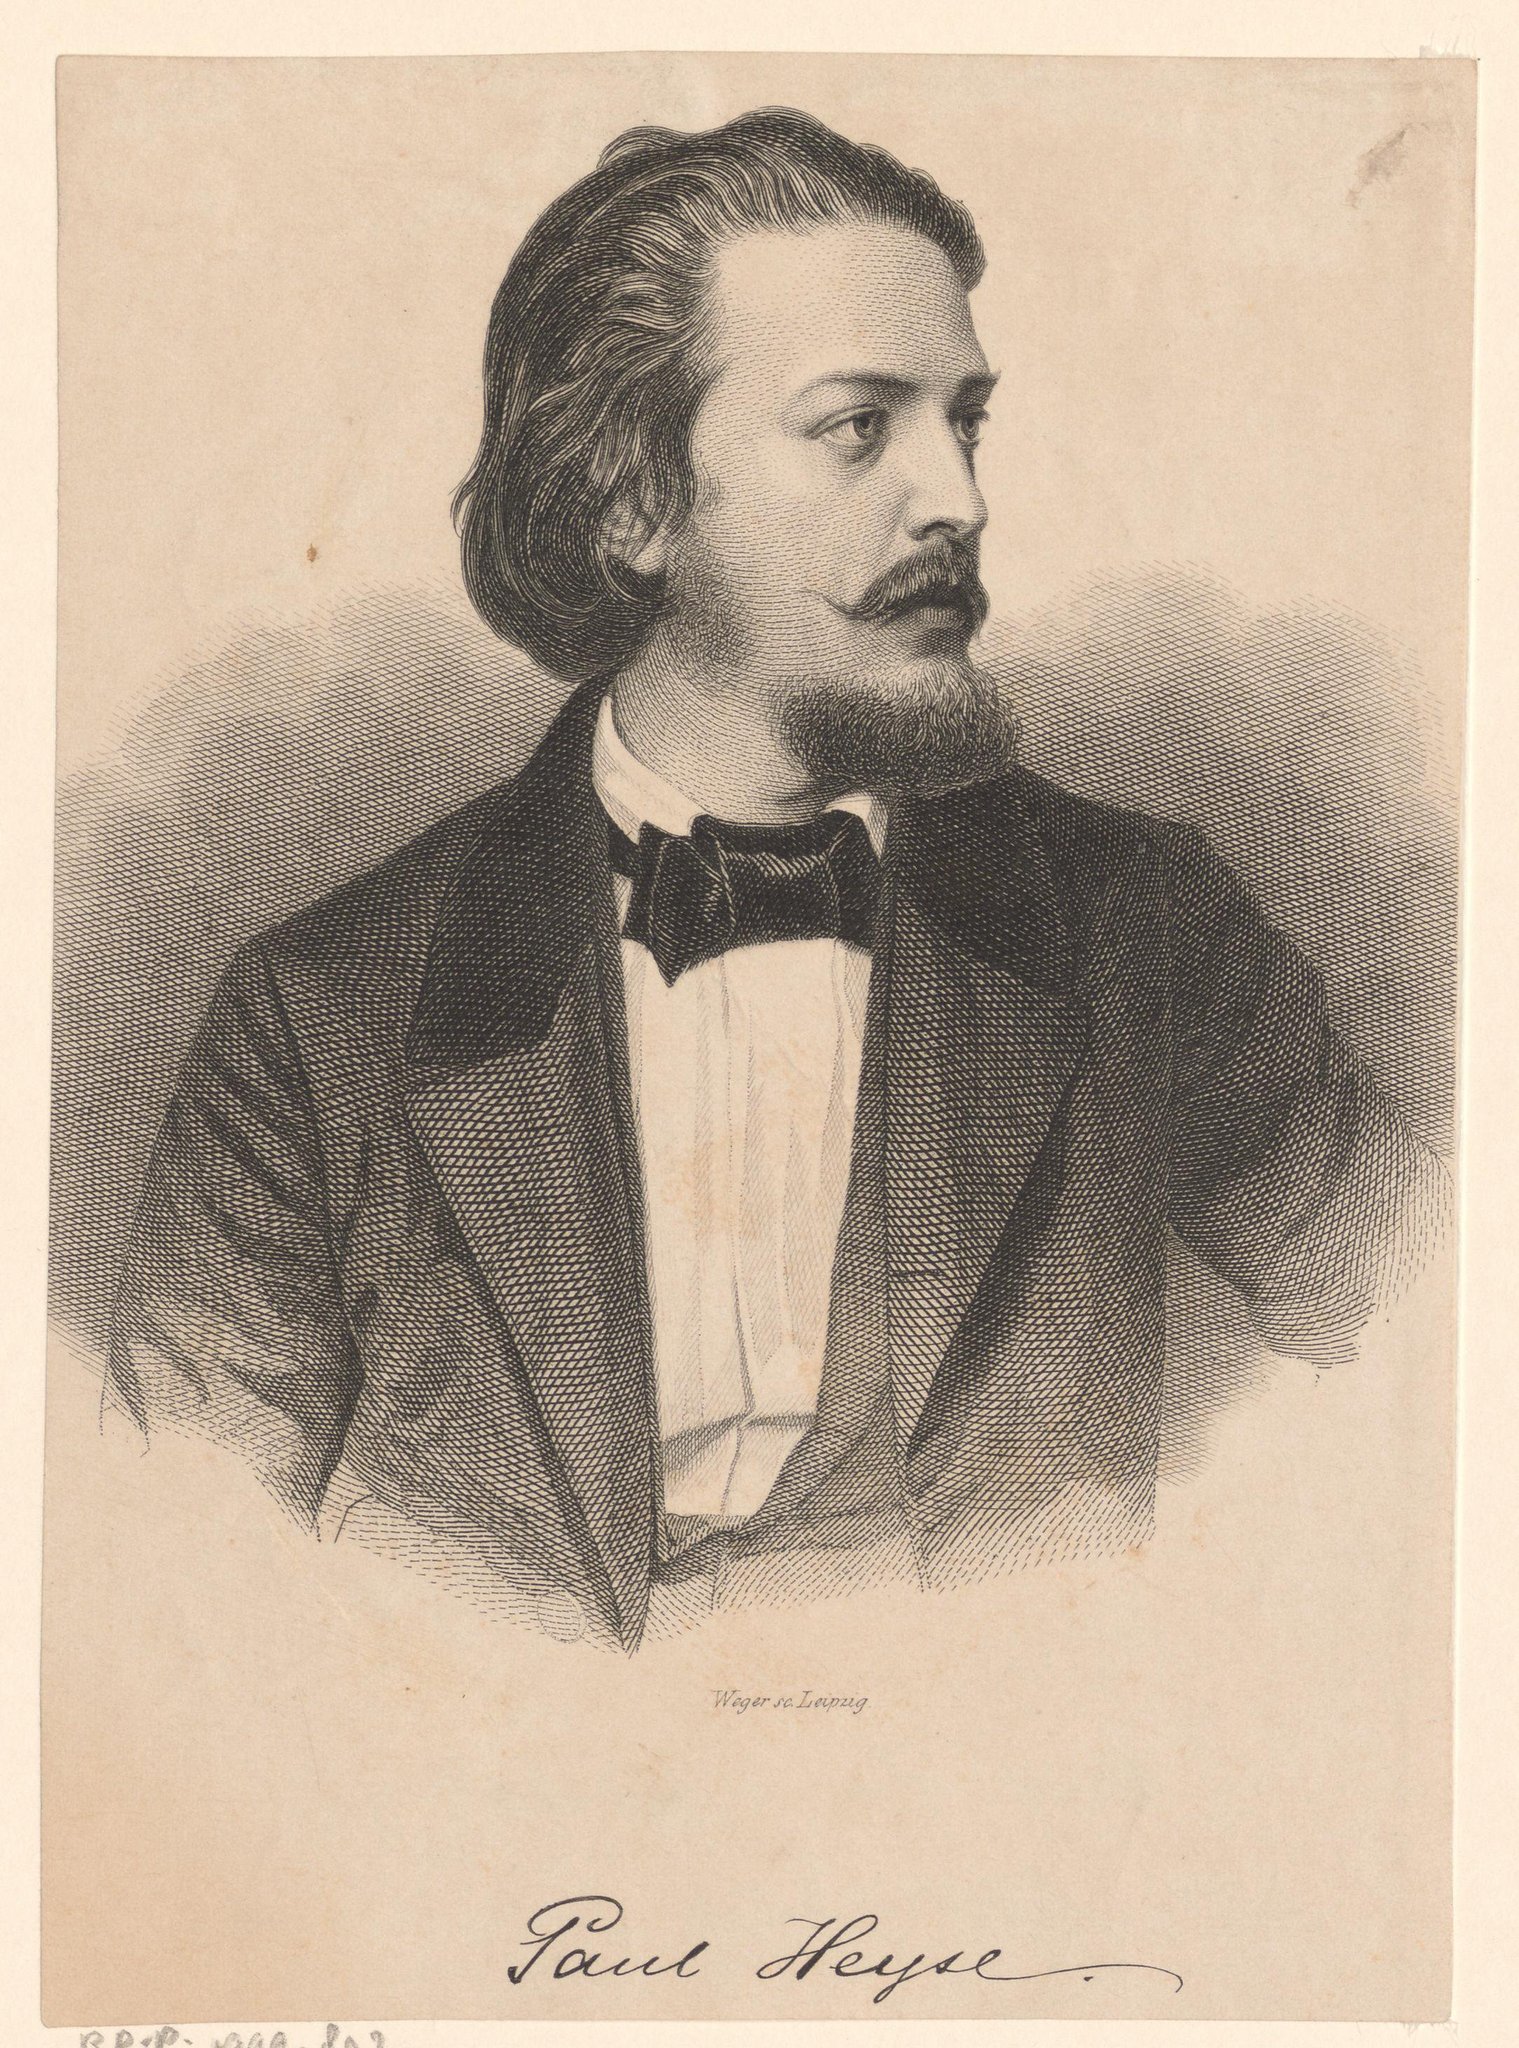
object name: print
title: Portret van Paul Heyse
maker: august weger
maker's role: print maker, printer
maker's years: 1823-1892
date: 1840-1892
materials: paper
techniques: engraving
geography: leipzig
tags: berlin, historical persons, portrait of a writer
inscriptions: collector's mark: Lugt 2228